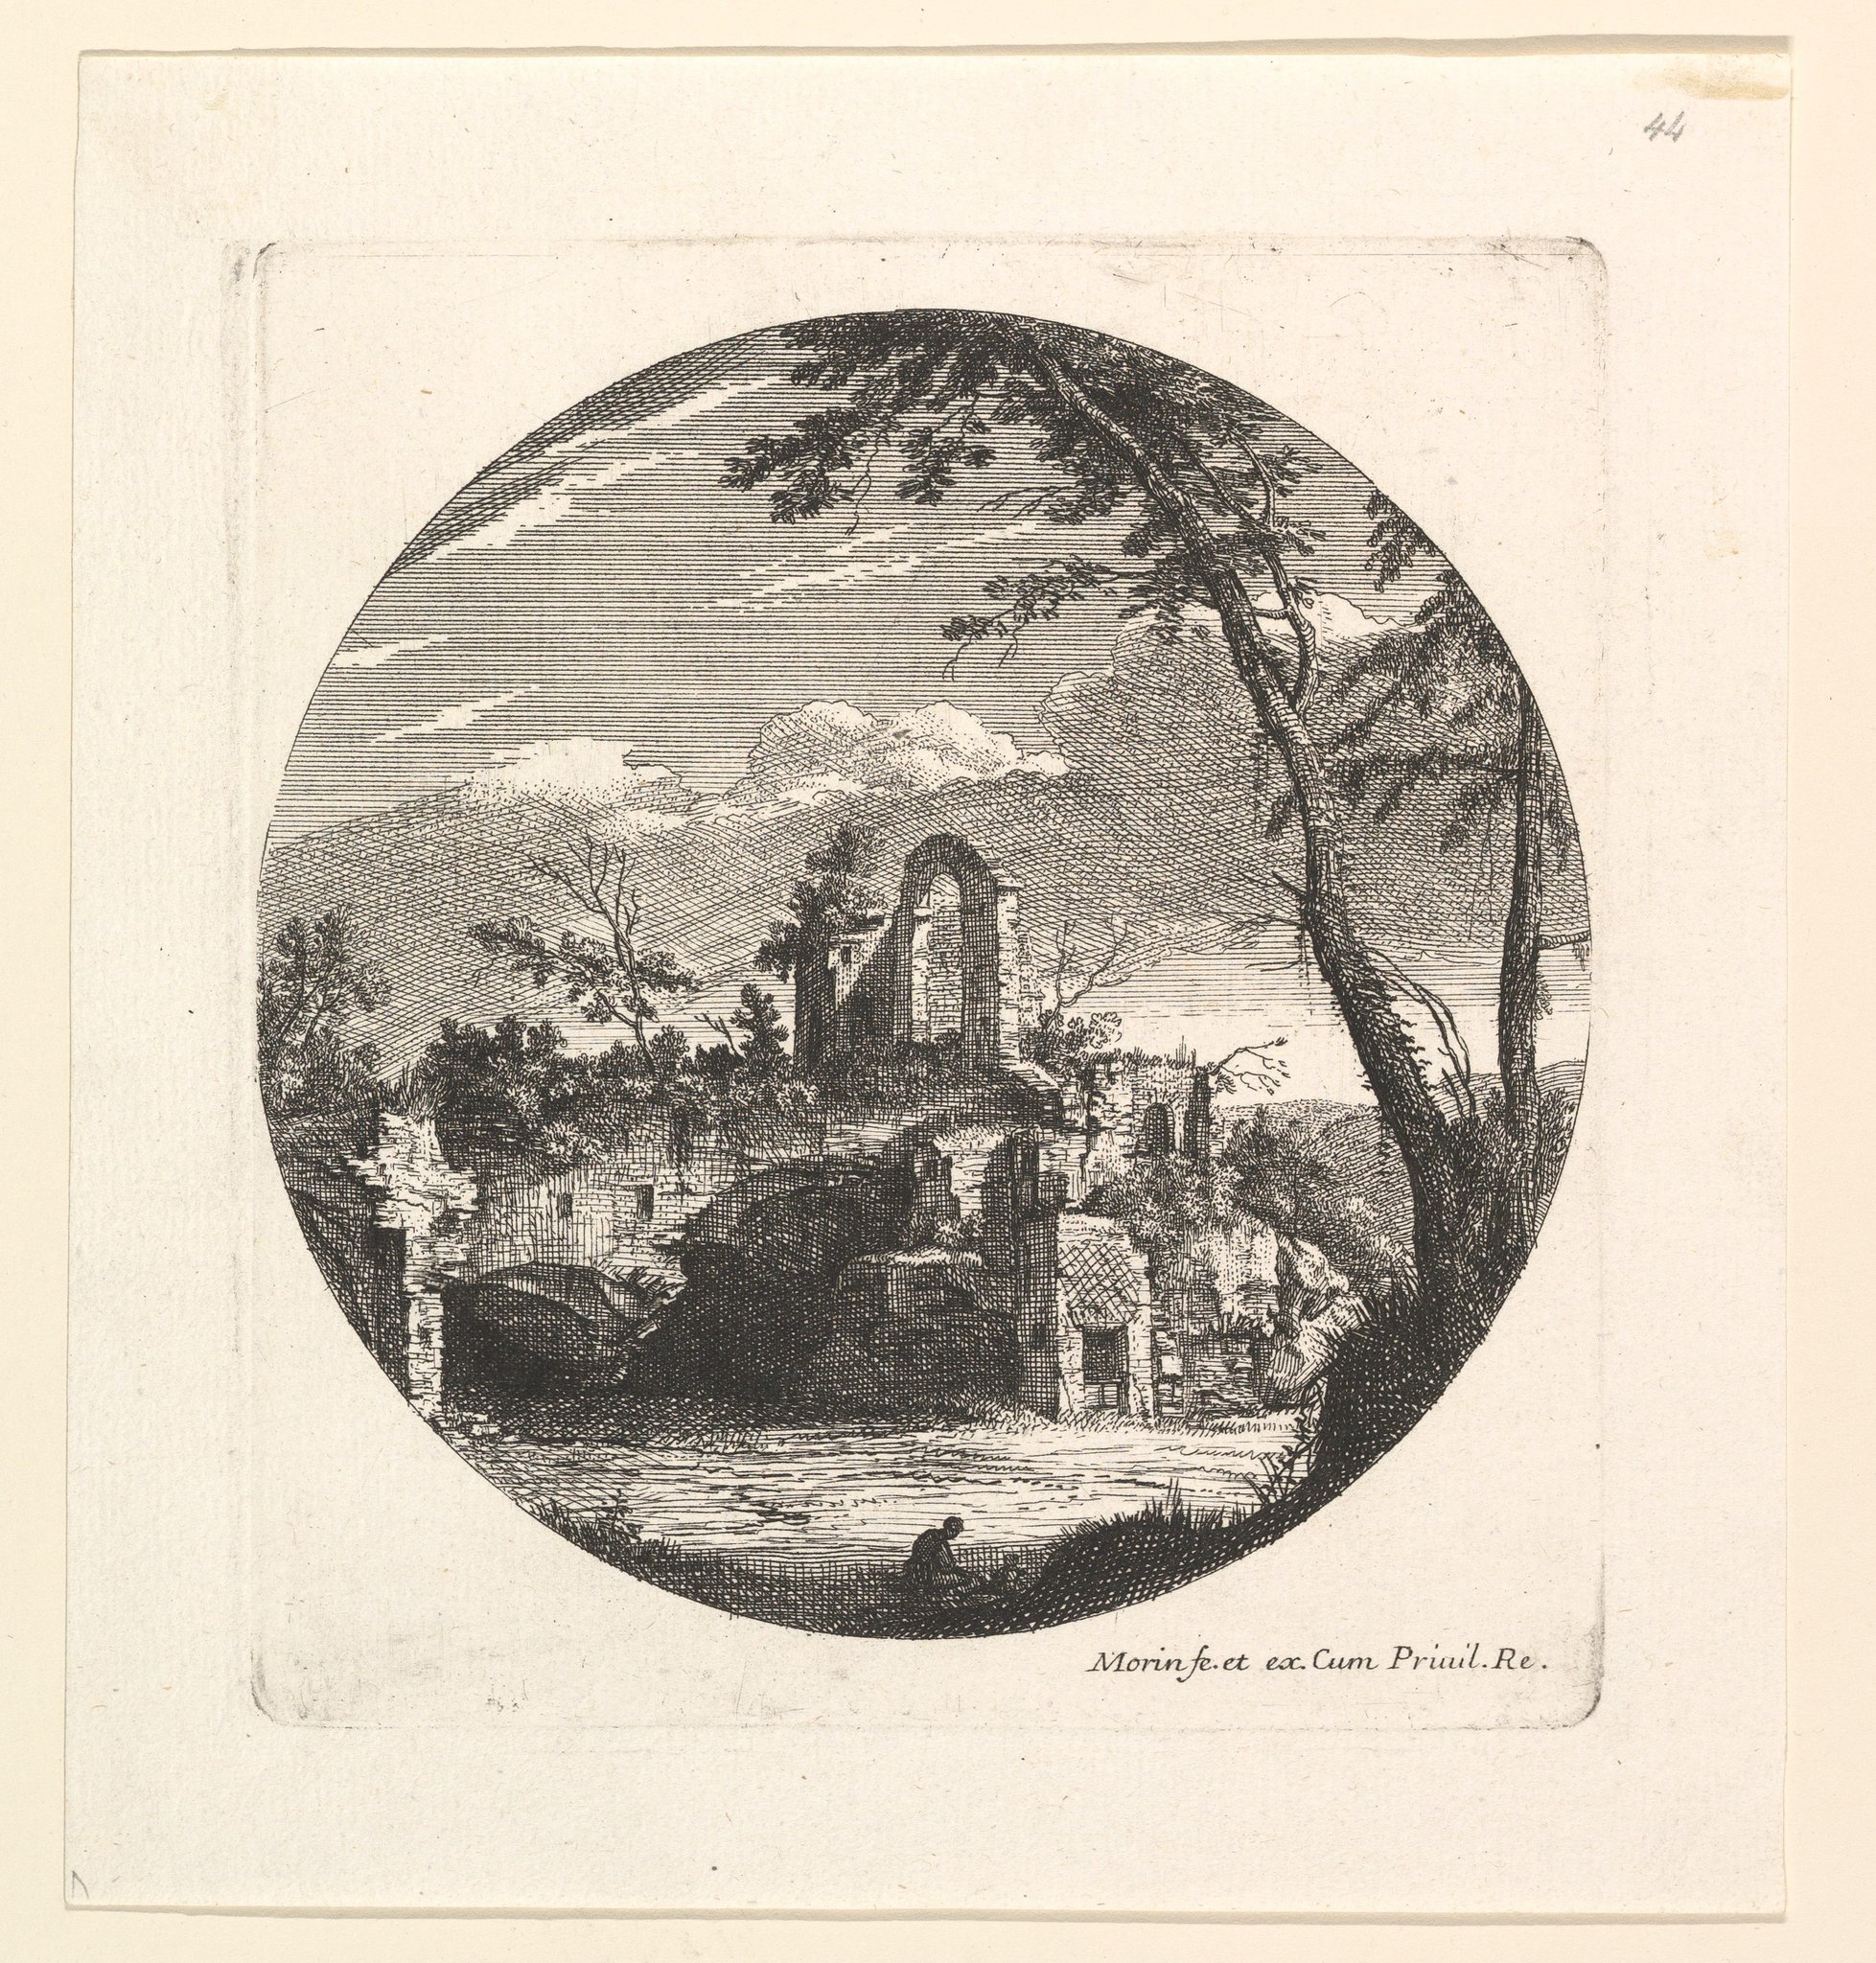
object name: print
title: Les Ruines au Fond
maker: jean morin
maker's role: artist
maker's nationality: french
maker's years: 1605-1650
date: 1605-1650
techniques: etching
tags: ruins